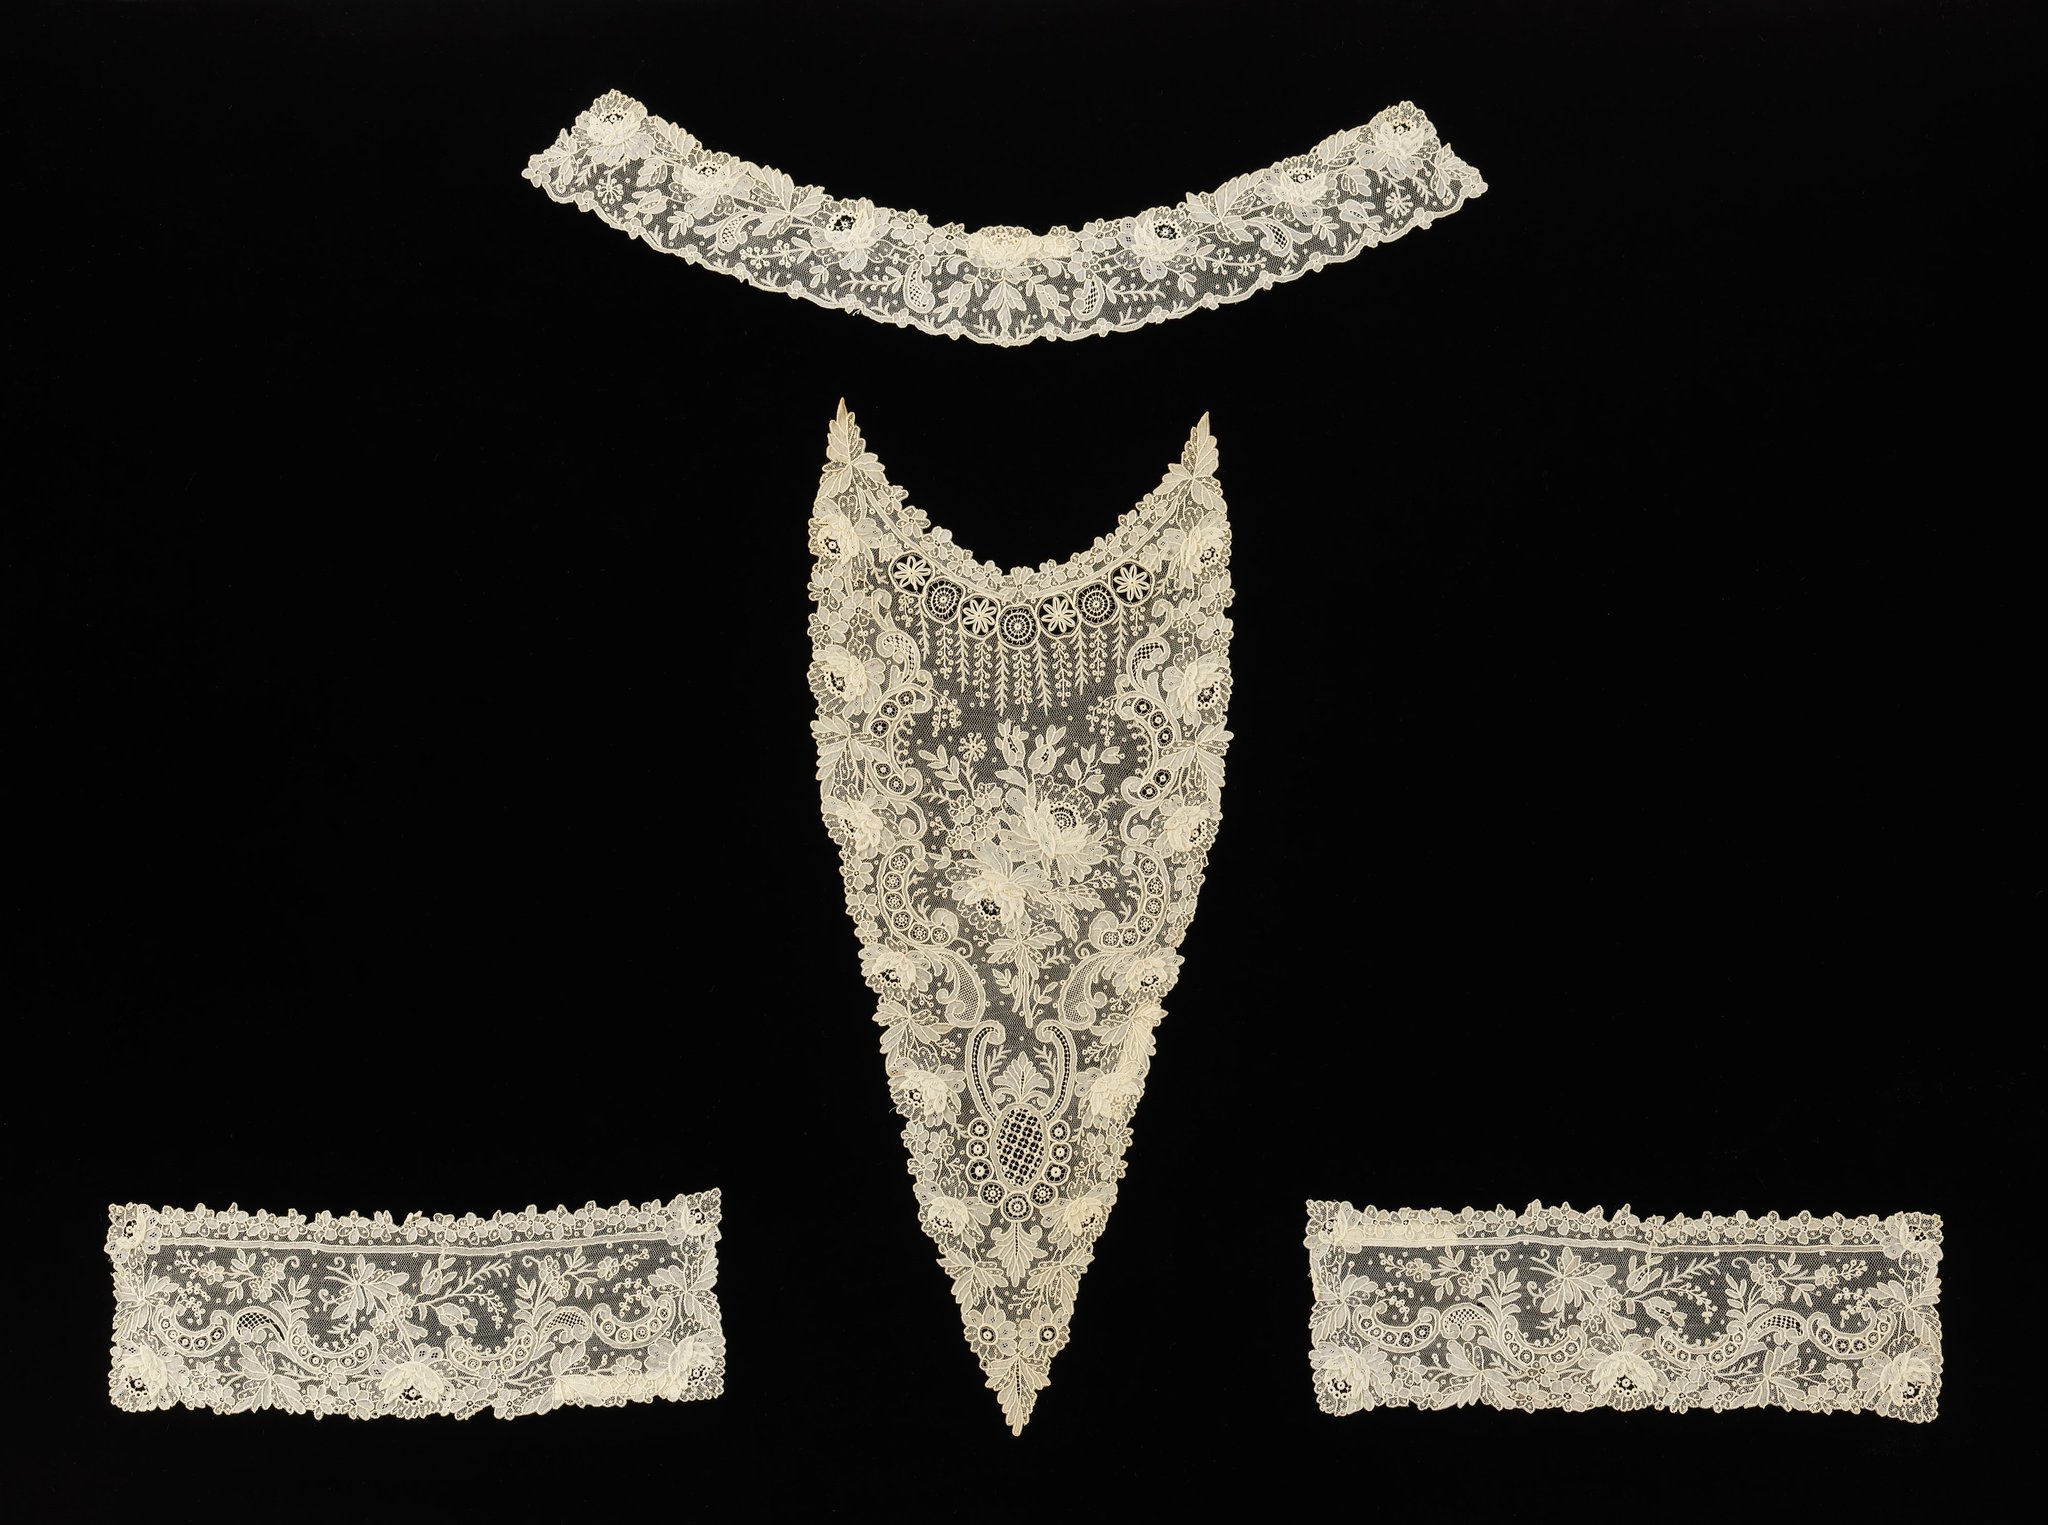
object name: accessory set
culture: belgian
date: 1895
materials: linen